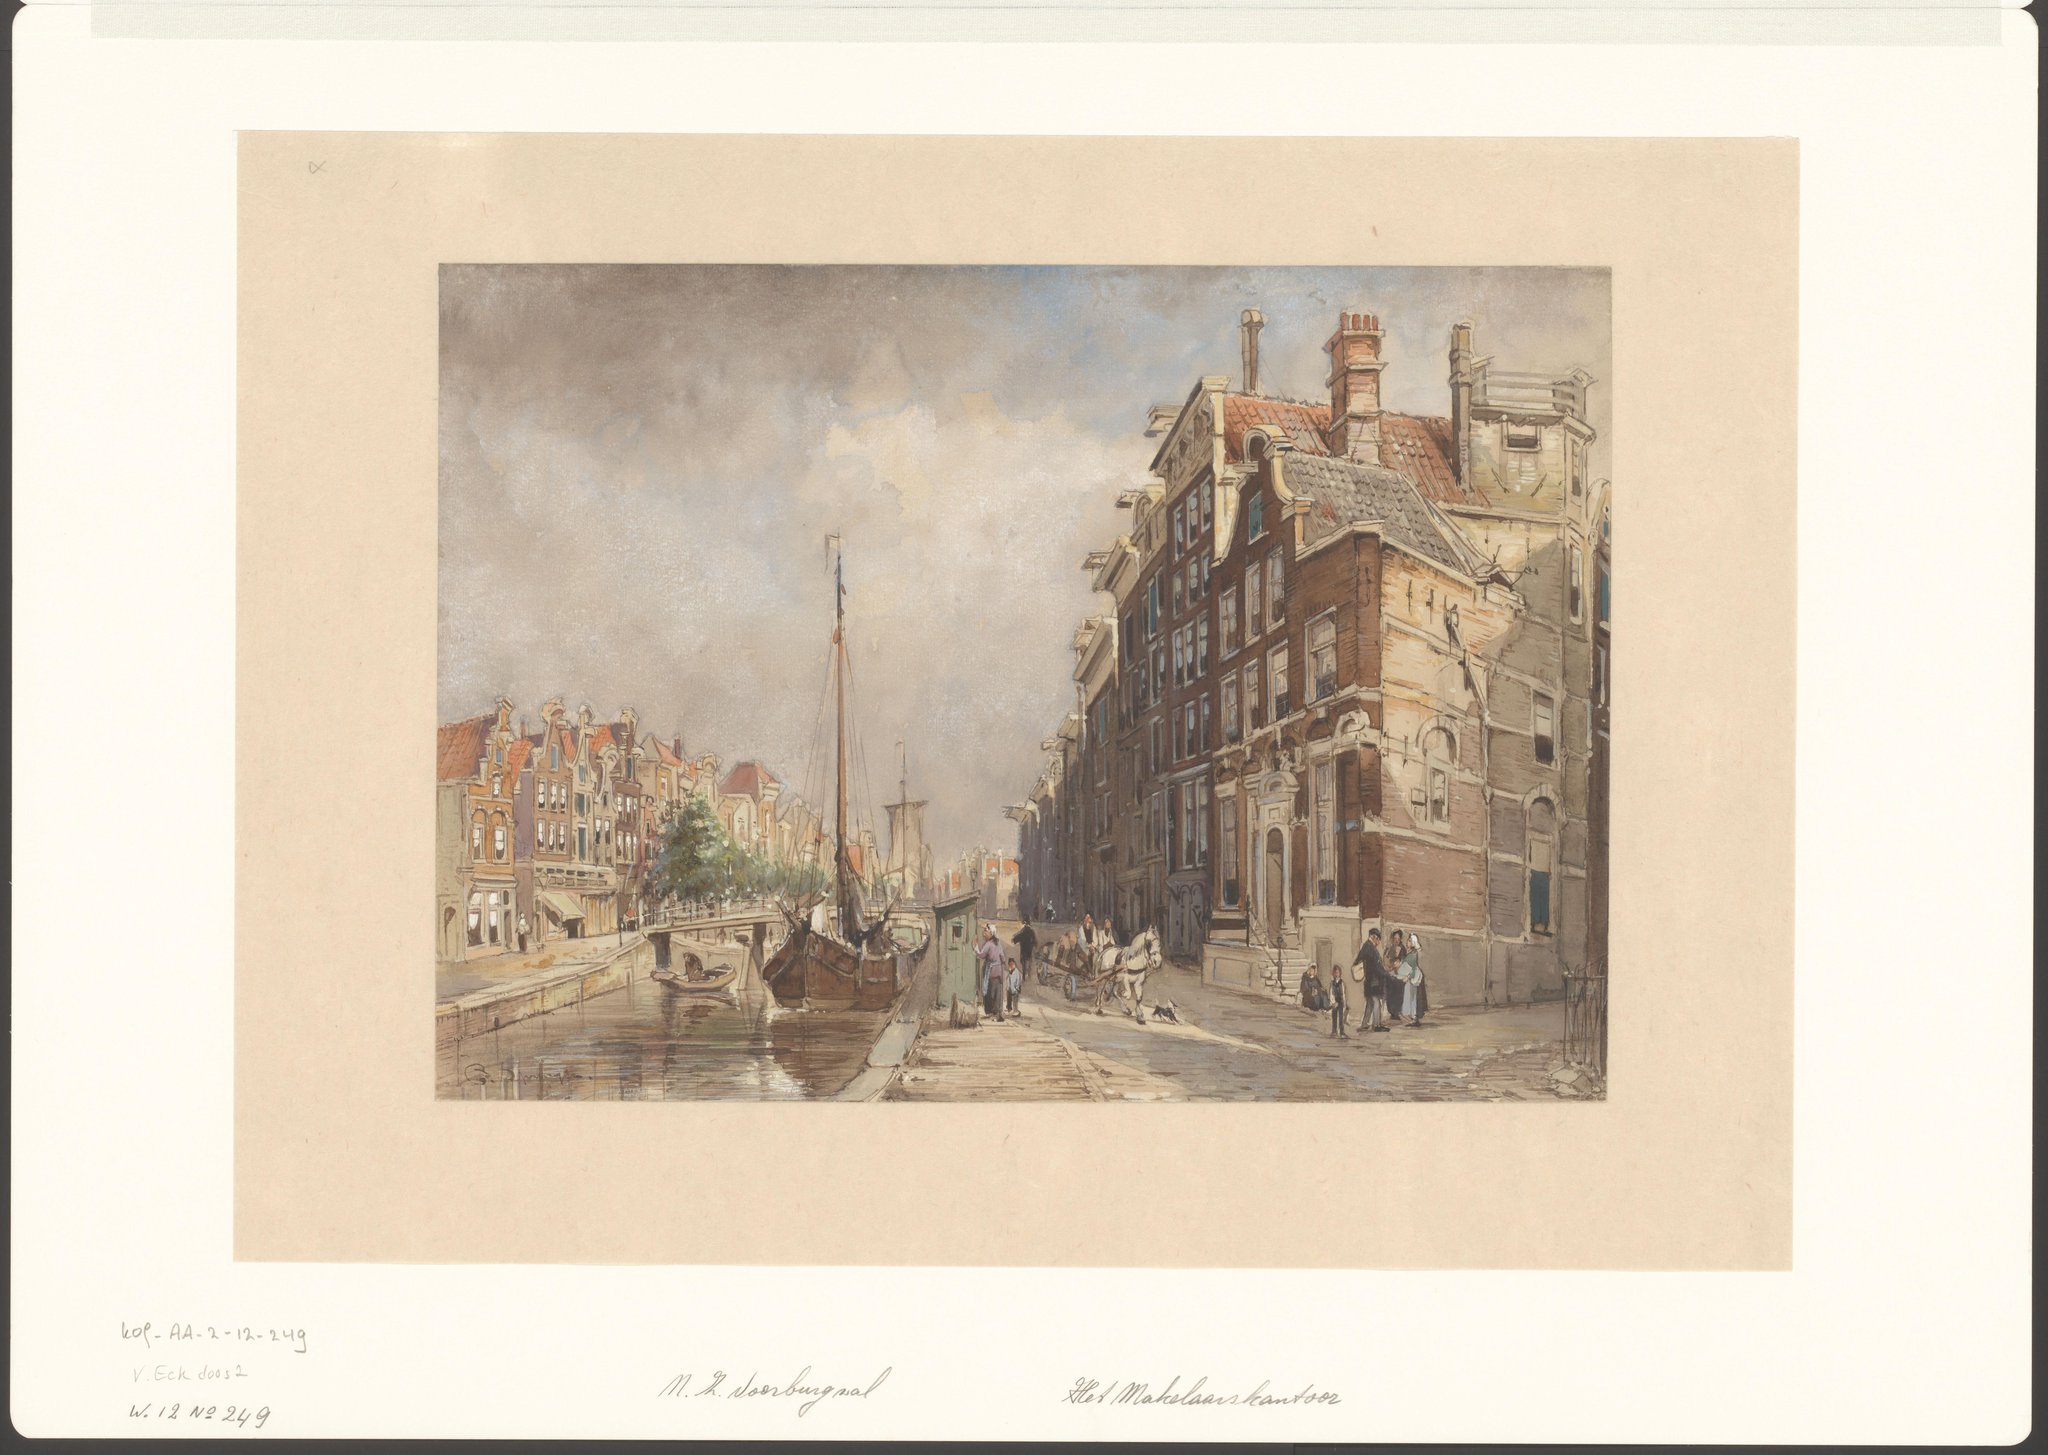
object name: drawing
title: Gezicht op een makelaarskantoor aan de Nieuwezijds Voorburgwal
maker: cornelis springer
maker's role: draughtsman, painter, print maker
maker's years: 1817-1891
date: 1827-1891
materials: paint, paper, pencil, watercolor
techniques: brush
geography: amsterdam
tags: city-view in general; 'veduta', canal, façade (of house or building), bridge in city across river, canal, etc.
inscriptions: signature: ‘C.Springer’, collector's mark: Lugt 800a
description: Tekening binnen de Atlas Van Eck ingedeeld op wijknummer 12.